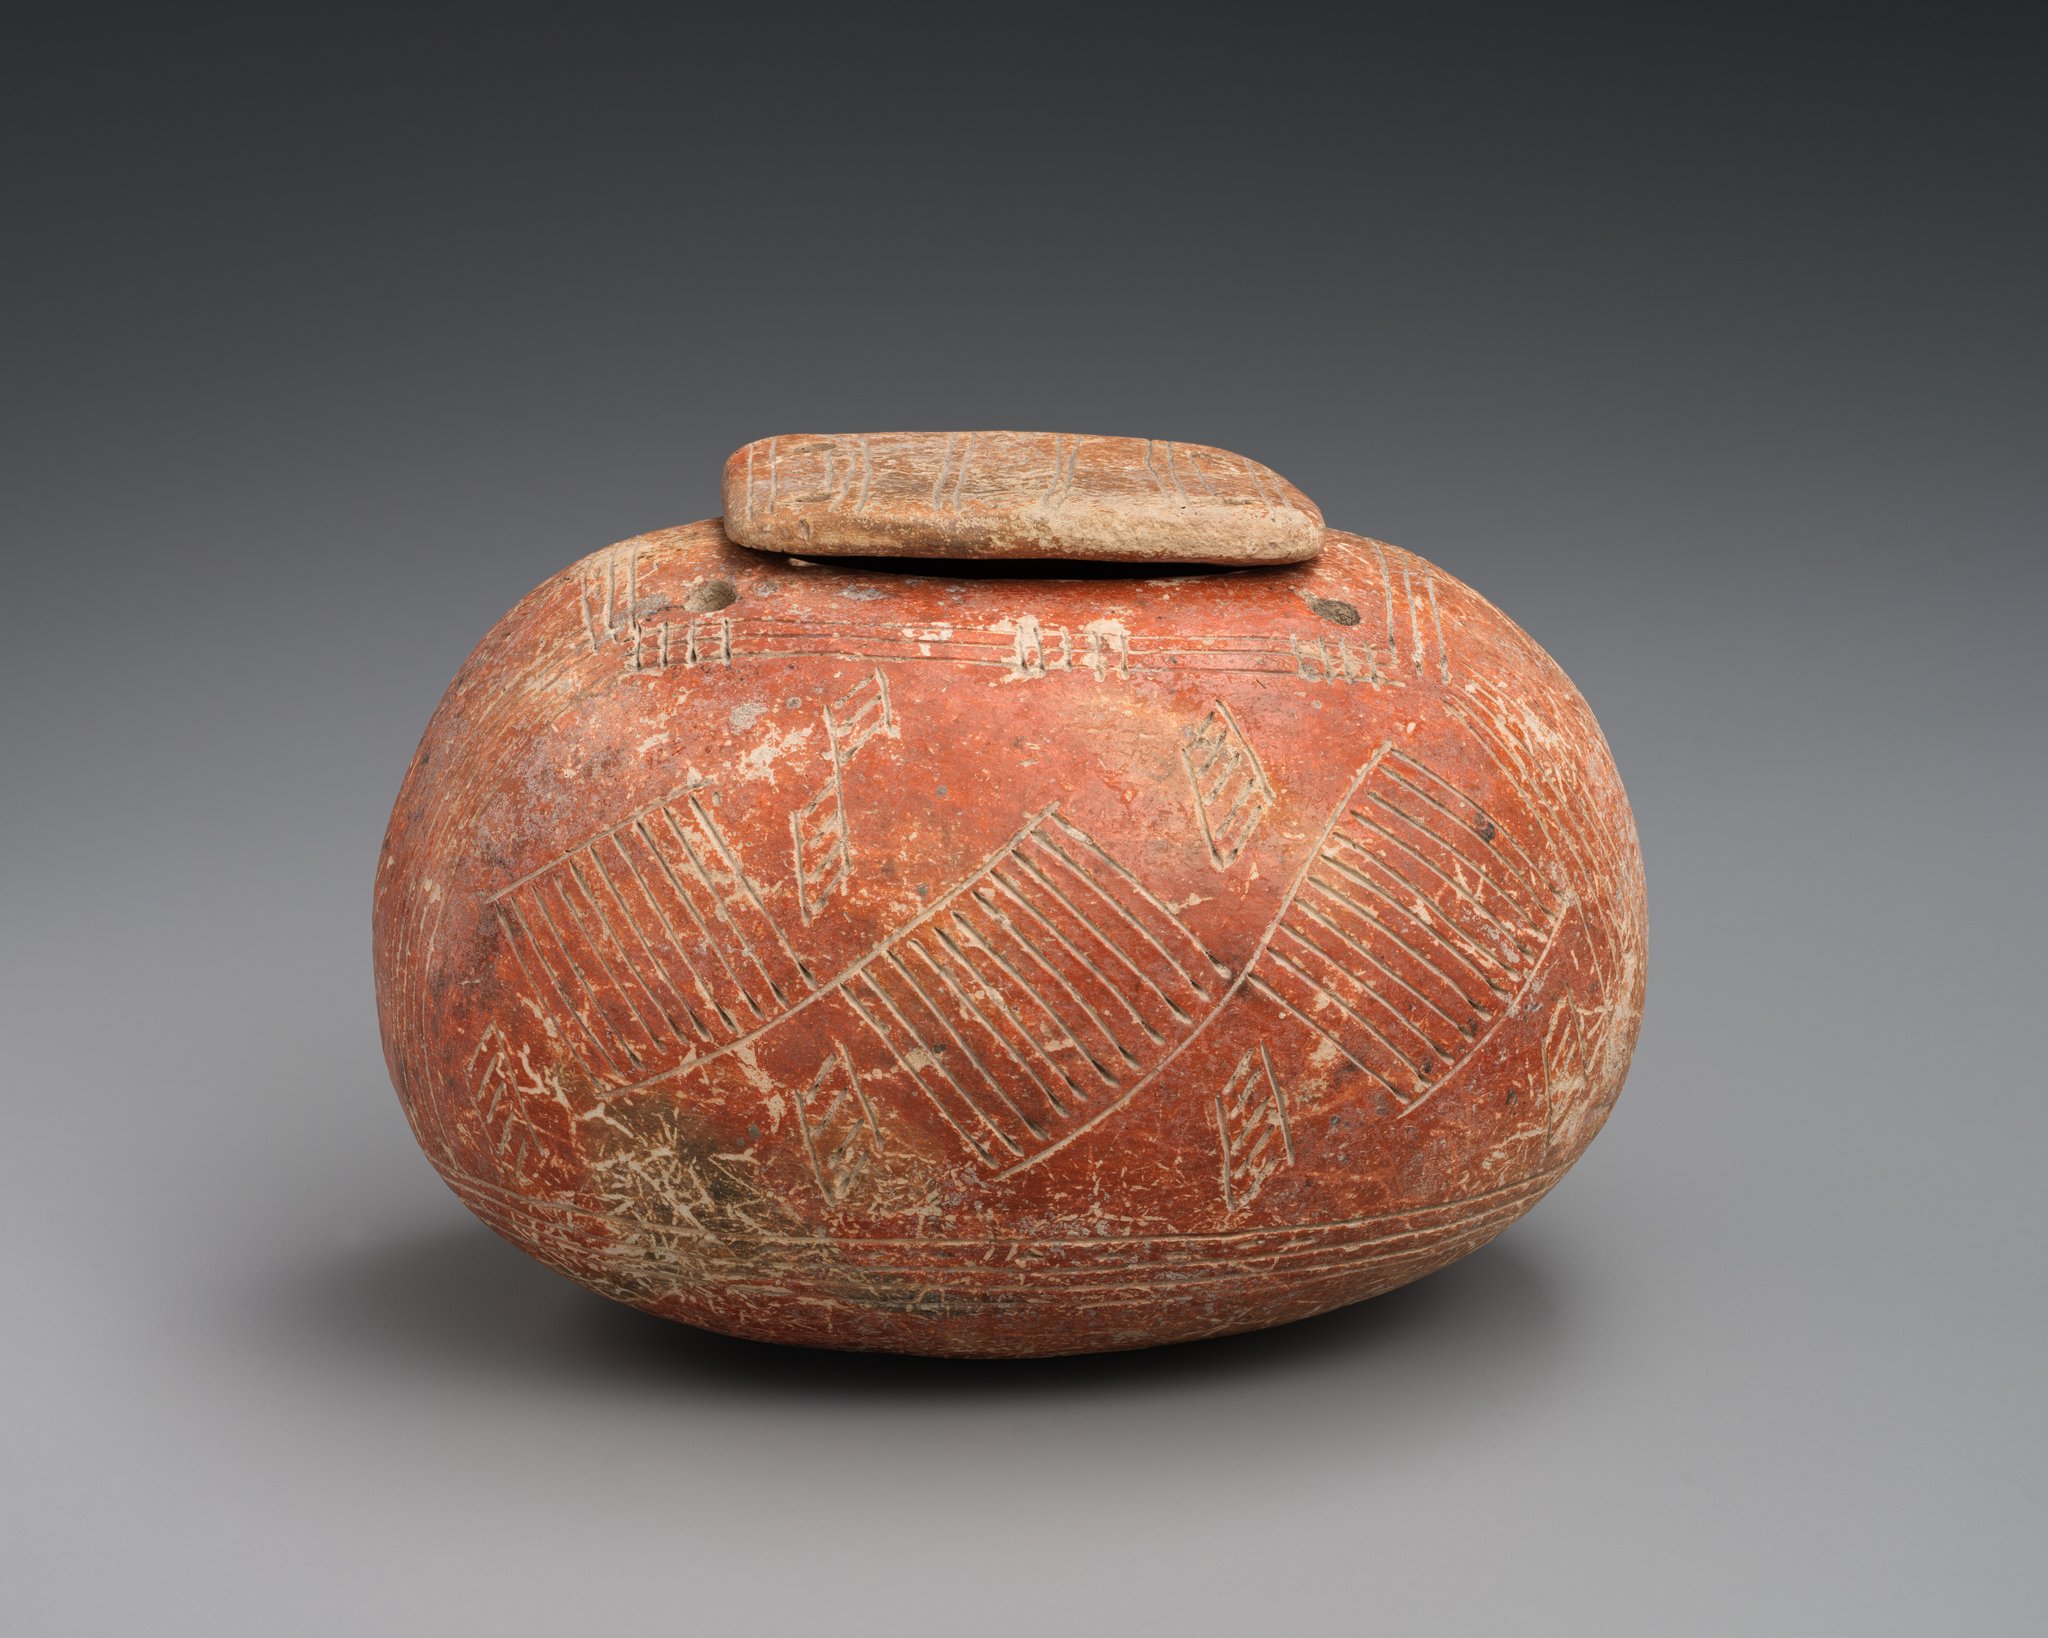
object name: pyxis with lid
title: Terracotta pyxis (box) with lid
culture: cypriot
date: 2000-1800 BCE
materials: terracotta